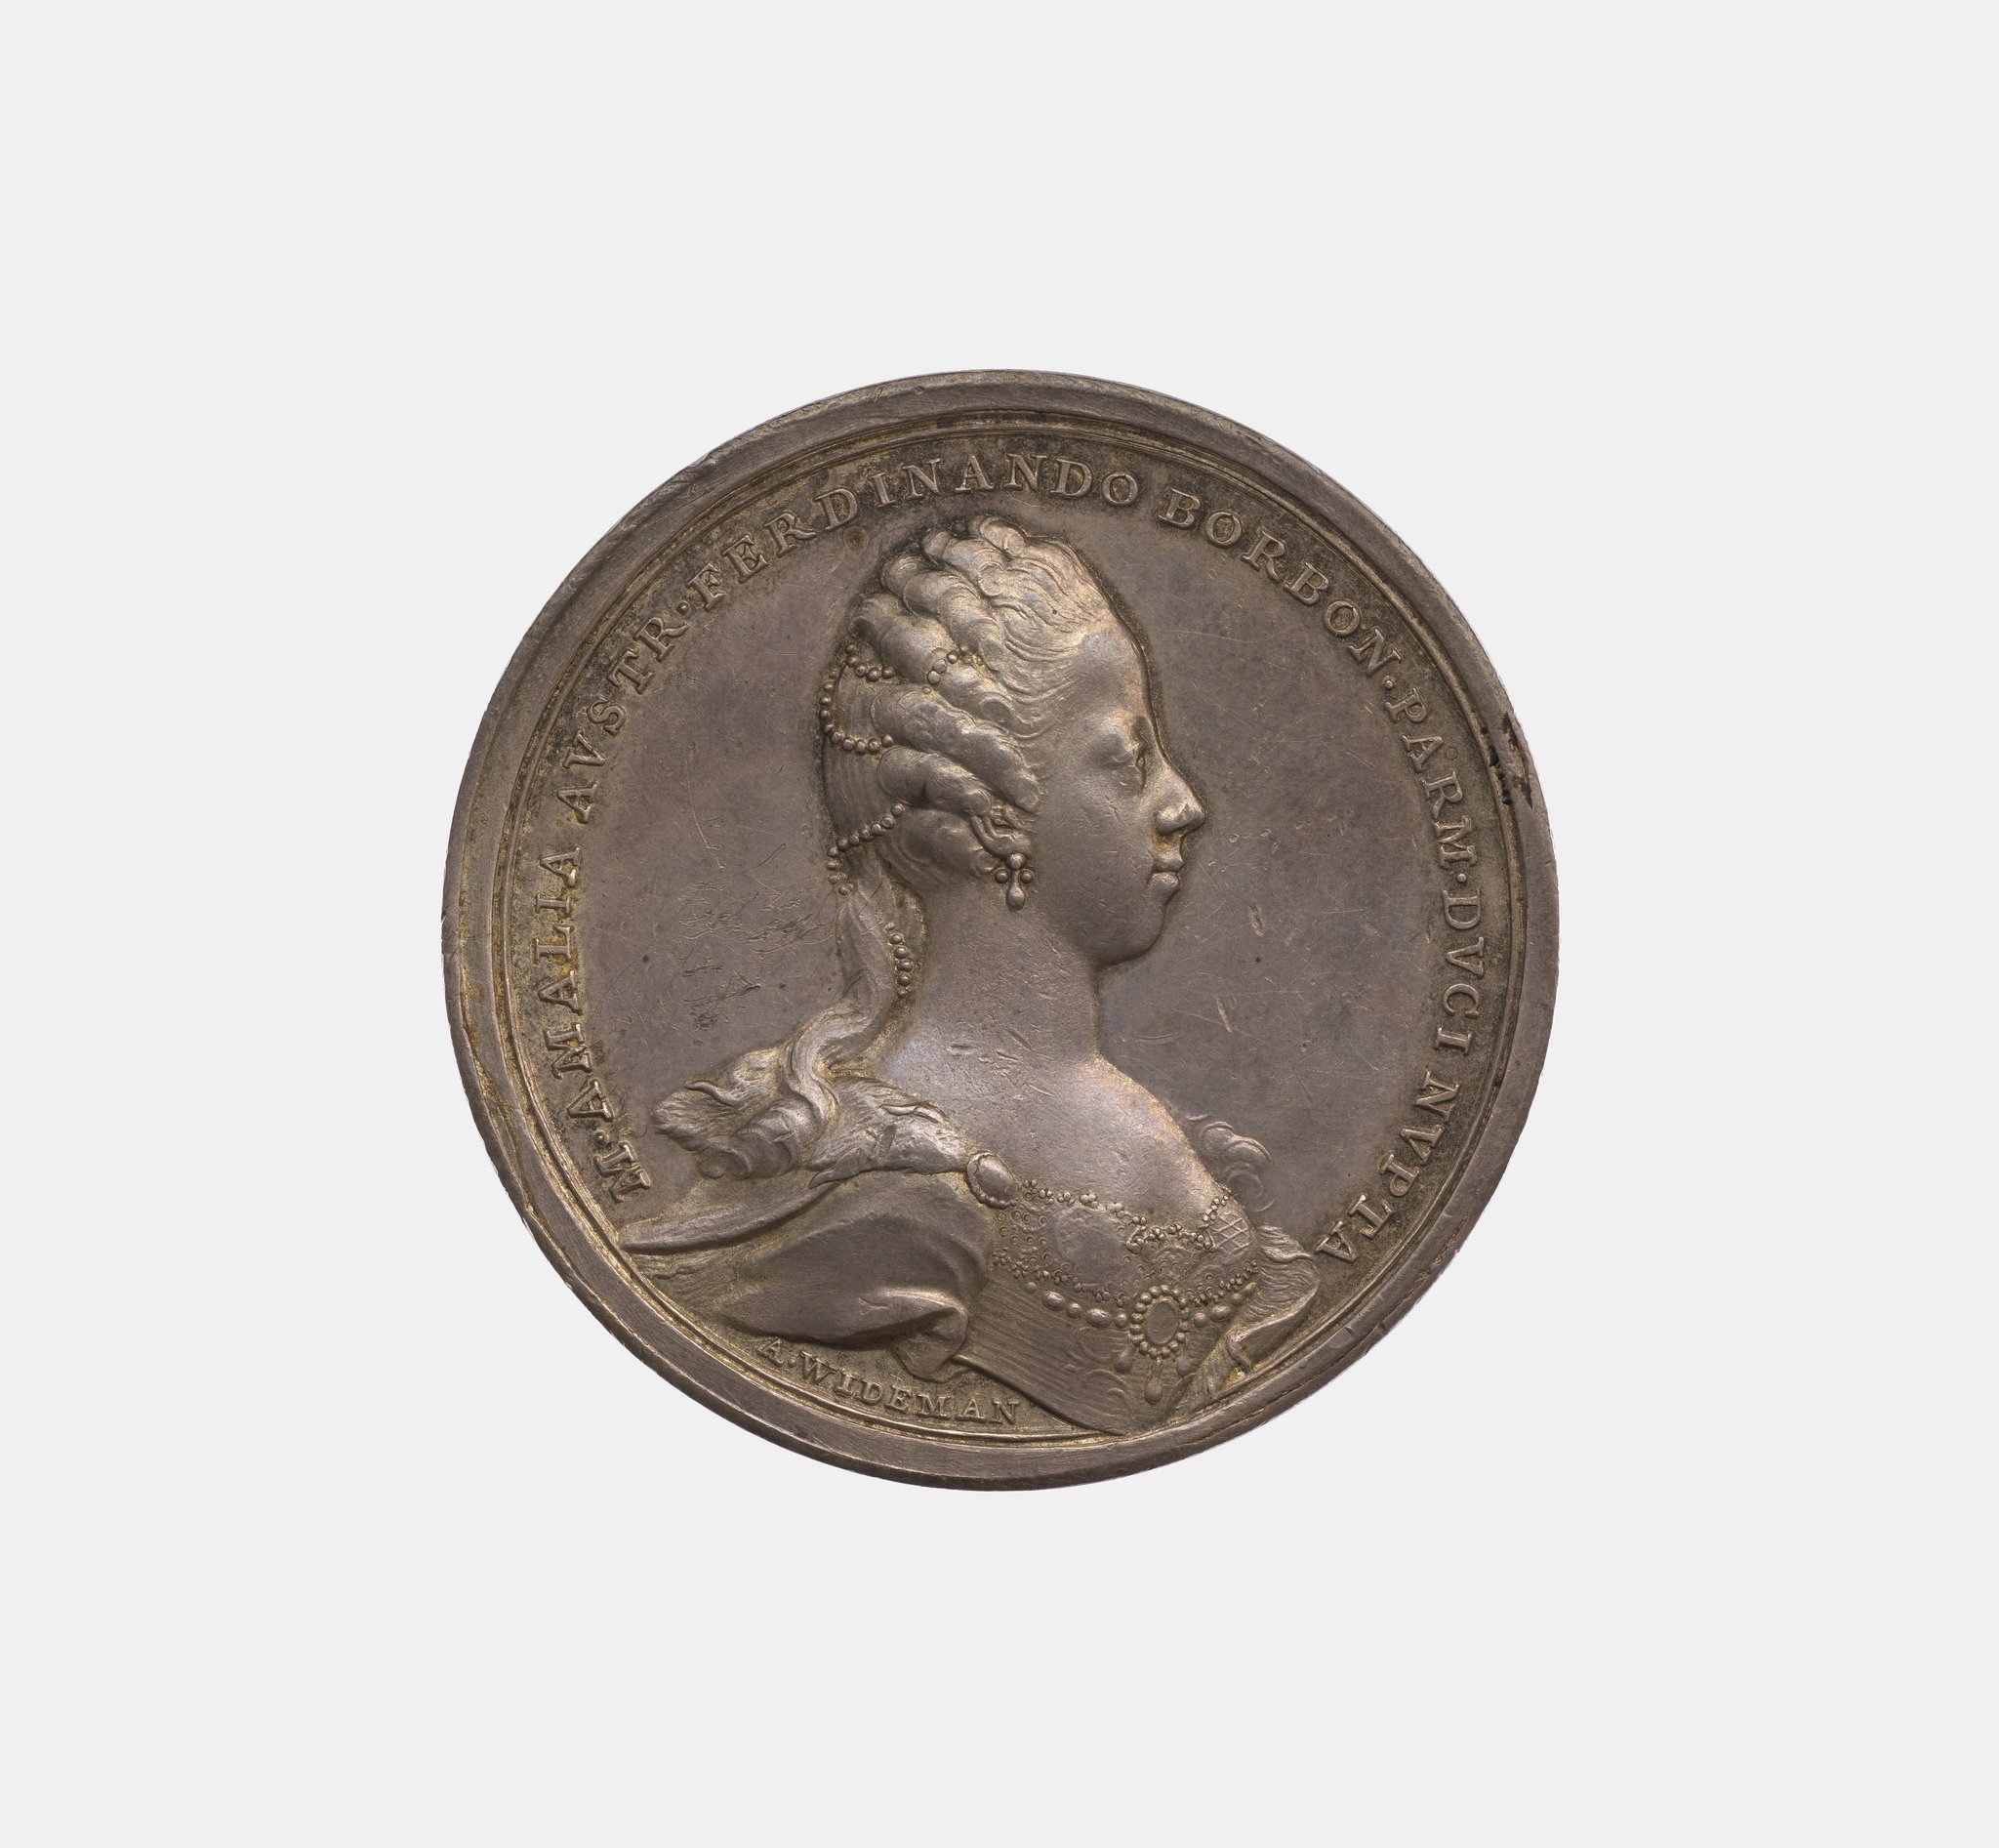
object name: medal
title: Marriage of Archduchess Maria Amalia with Ferdinand, Duke of Parma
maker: anton franz widemann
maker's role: artist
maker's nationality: austrian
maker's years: 1724-1792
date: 1769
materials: silver